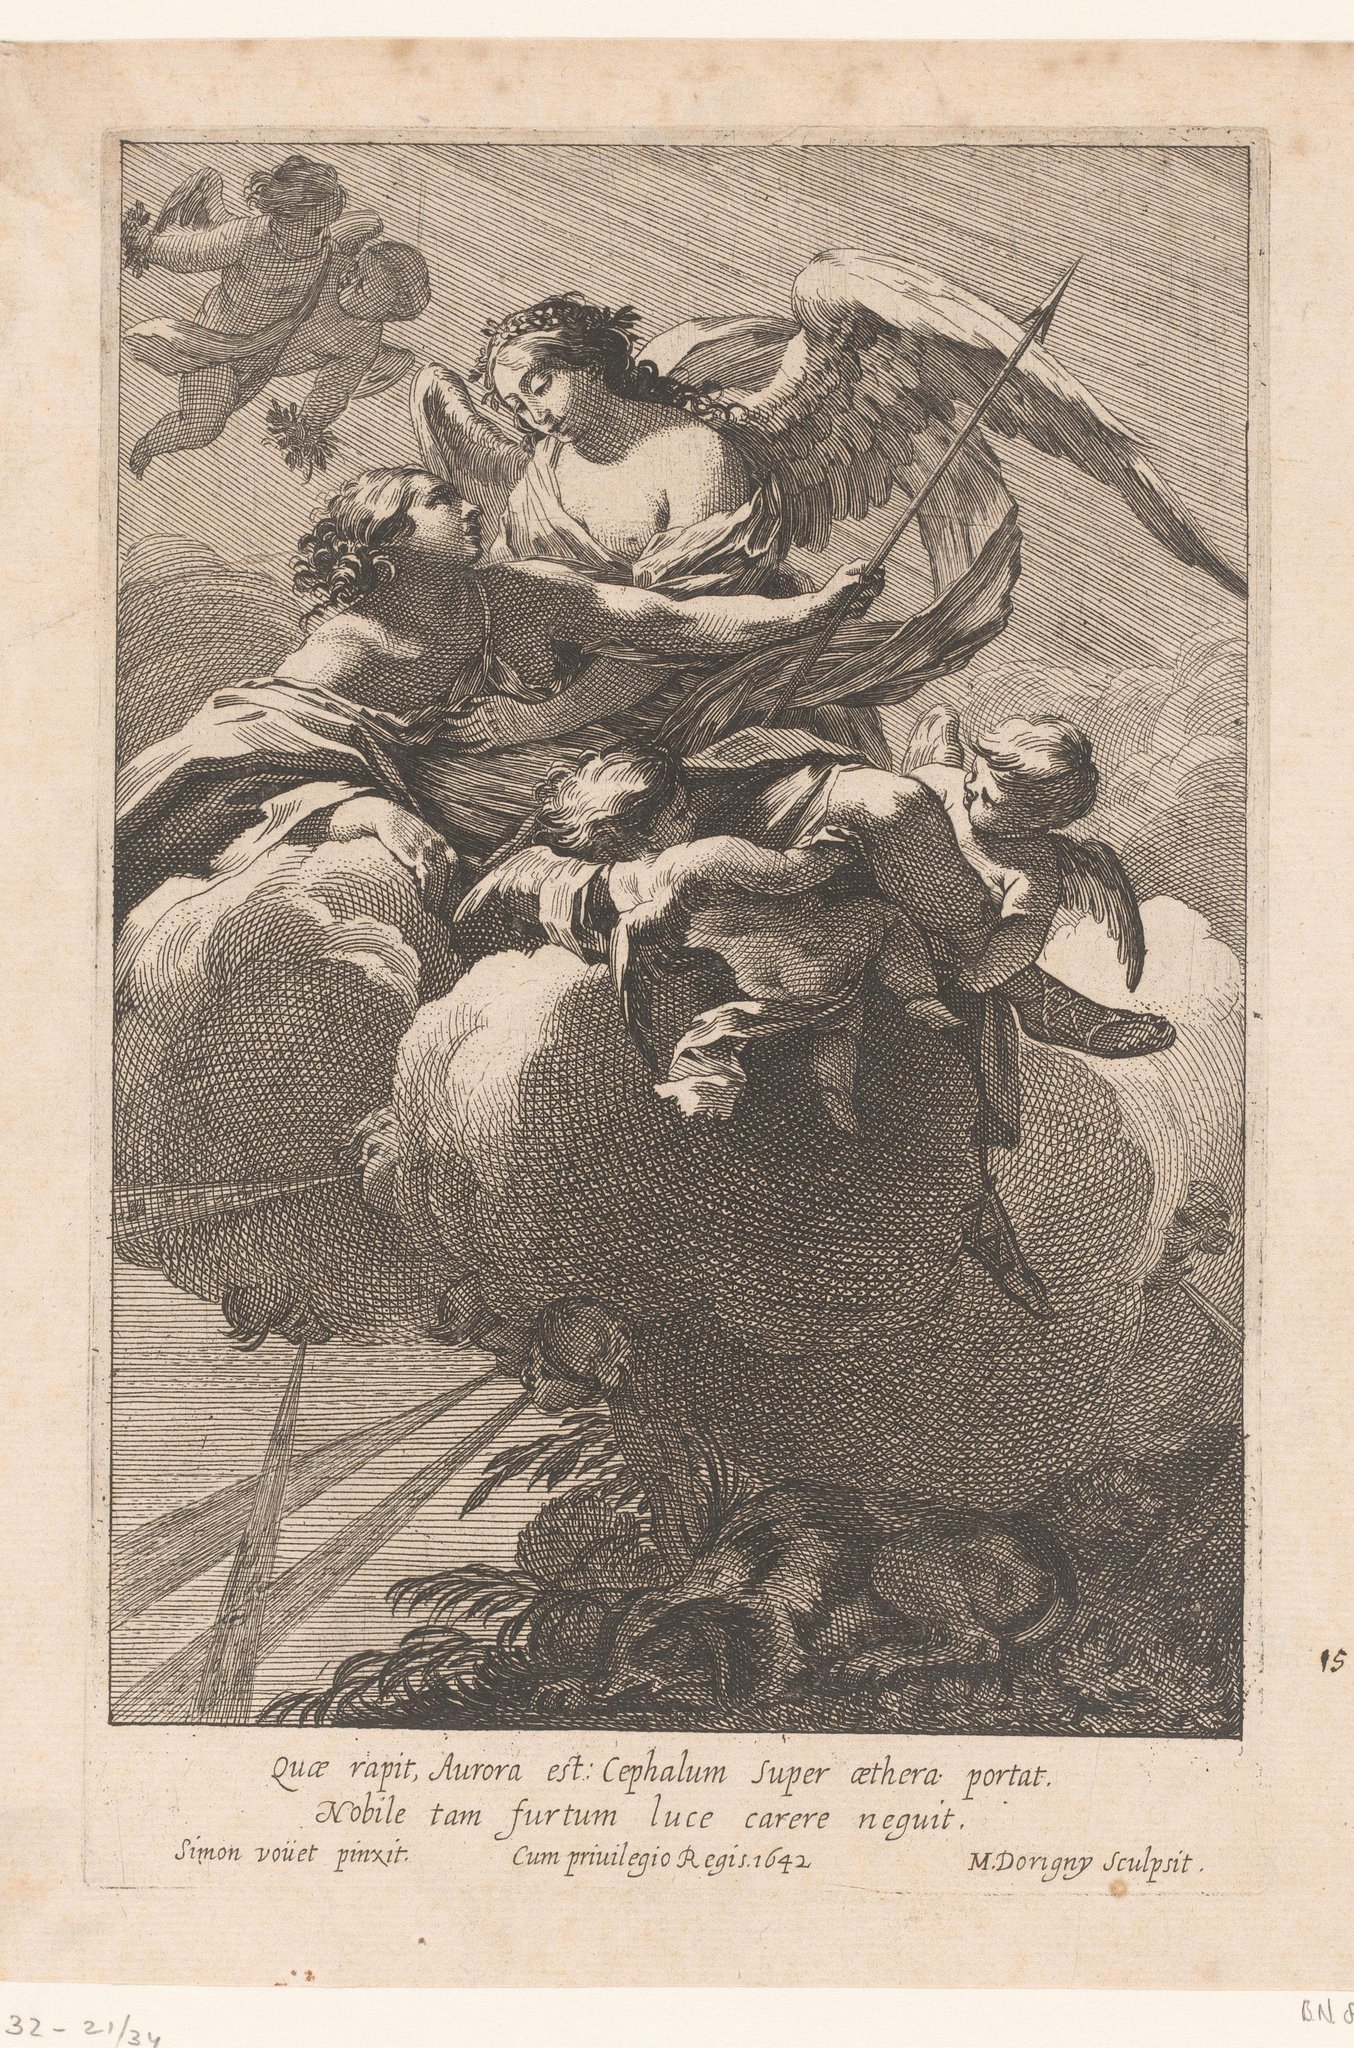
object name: print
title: Aurora en Cephalus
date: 1642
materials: paper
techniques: engraving, etching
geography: france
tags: aurora carrying off cephalus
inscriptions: collector's mark: ‘Hinloopen’, collector's mark: Lugt 11